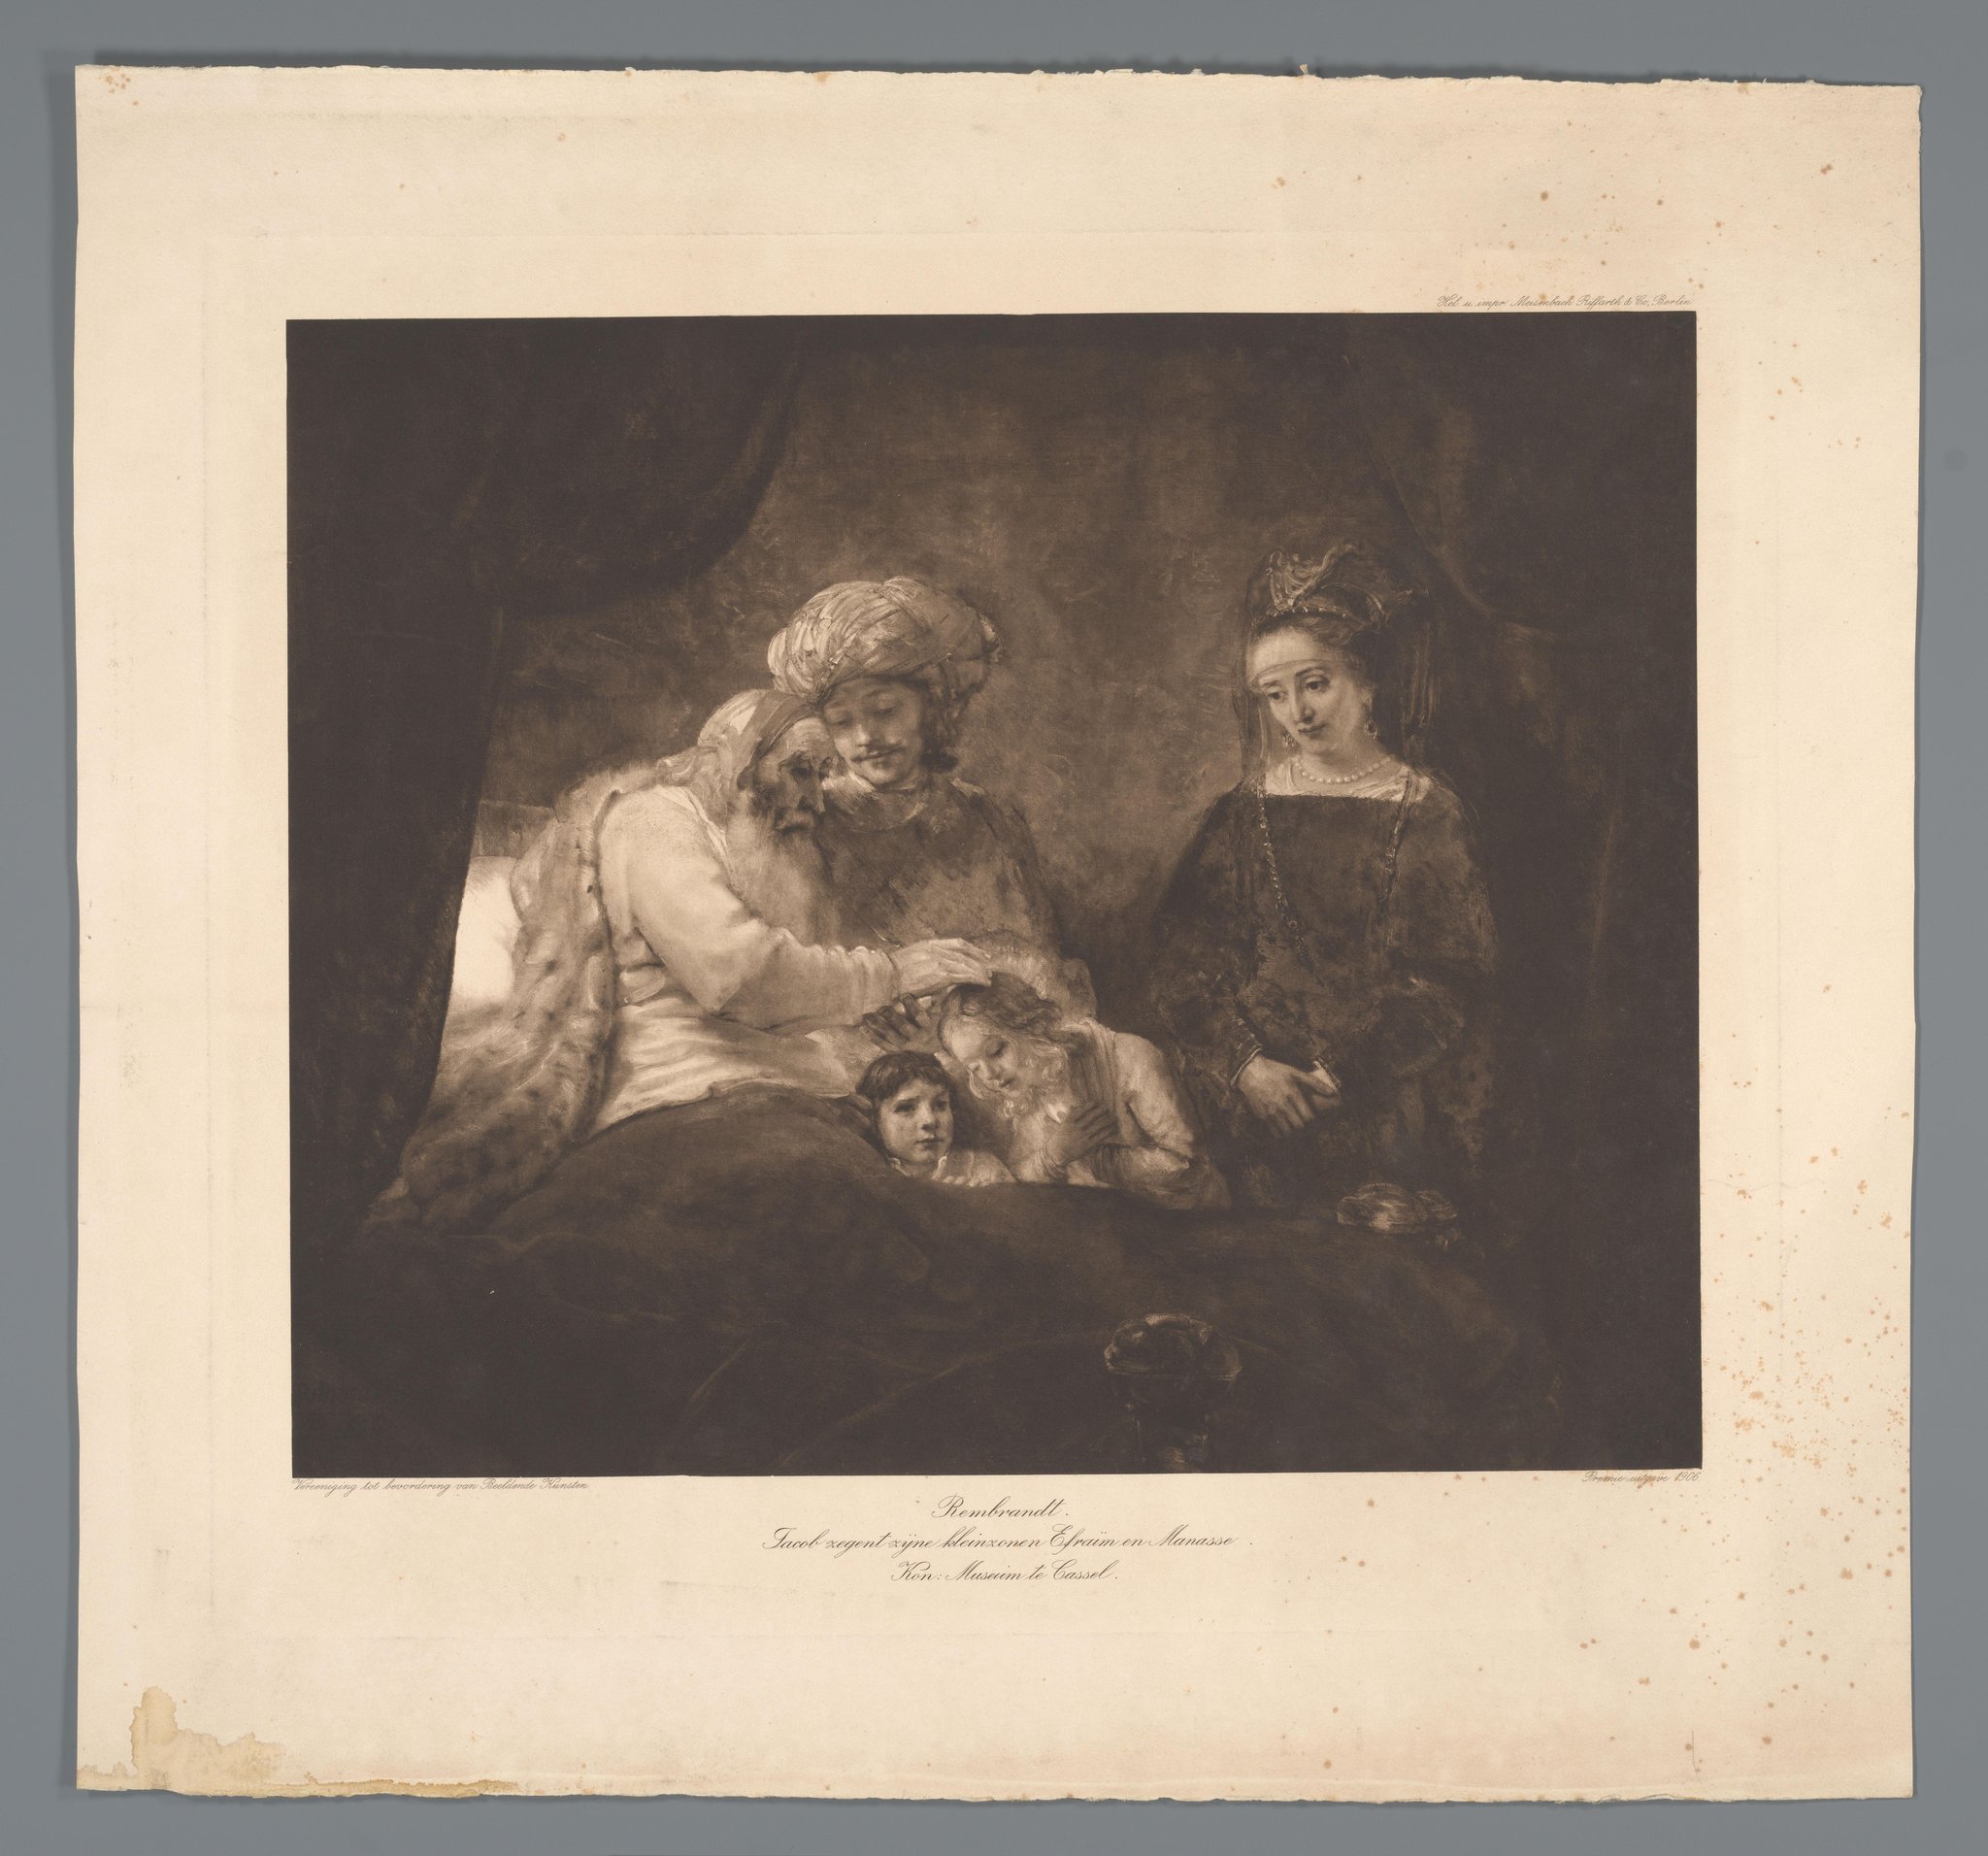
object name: photomechanical print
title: Reproductie van het schilderij Jakob zegent de zonen van Jozef door Rembrandt van Rijn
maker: rembrandt van rijn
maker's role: draughtsman, painter, print maker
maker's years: 1606-1669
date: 1892-1923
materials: cardboard, paper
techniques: photoaquatint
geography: berlin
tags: jacob blesses his sons, jacob blesses manasseh and ephraim with arms crossed; joseph may be shown trying to uncross them or expressing (with asenath) his disapproval, picture, painting